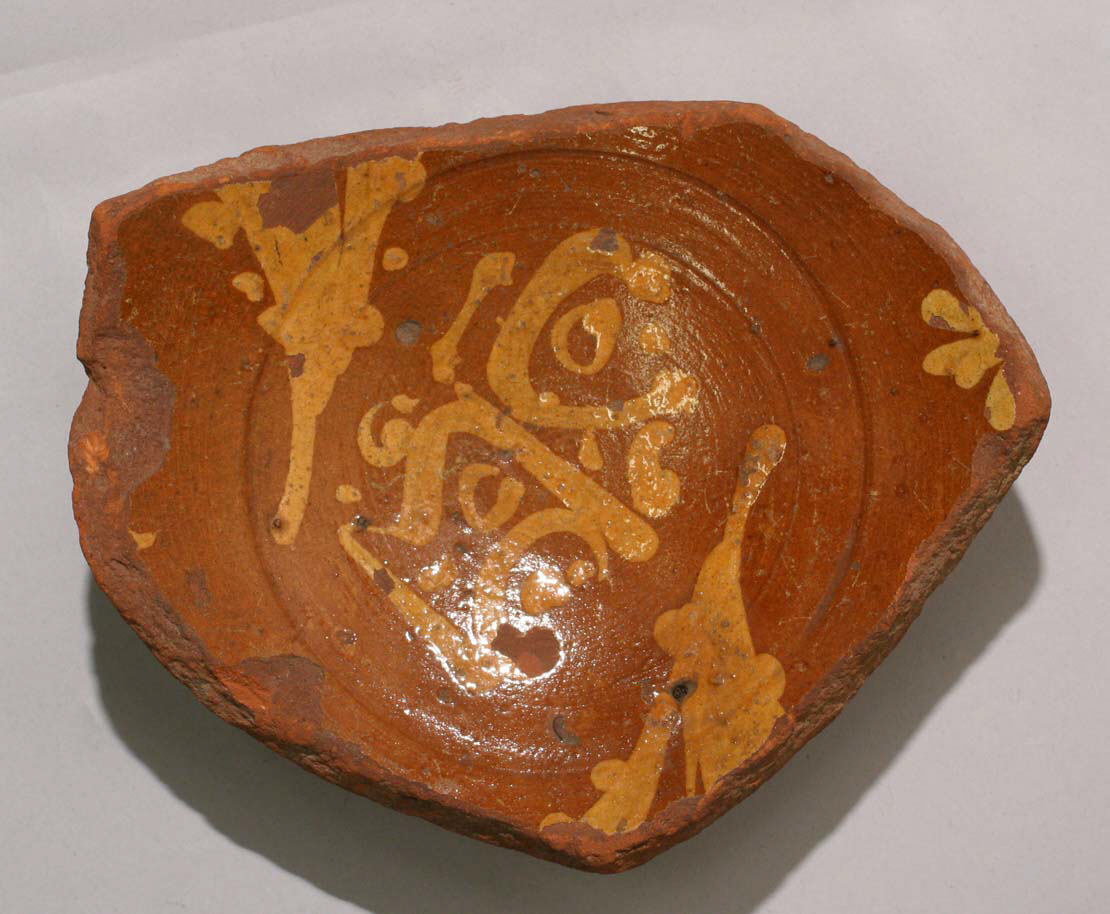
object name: fragment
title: Ceramic Fragment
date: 1301-1500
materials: earthenware, glaze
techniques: painting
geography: egypt